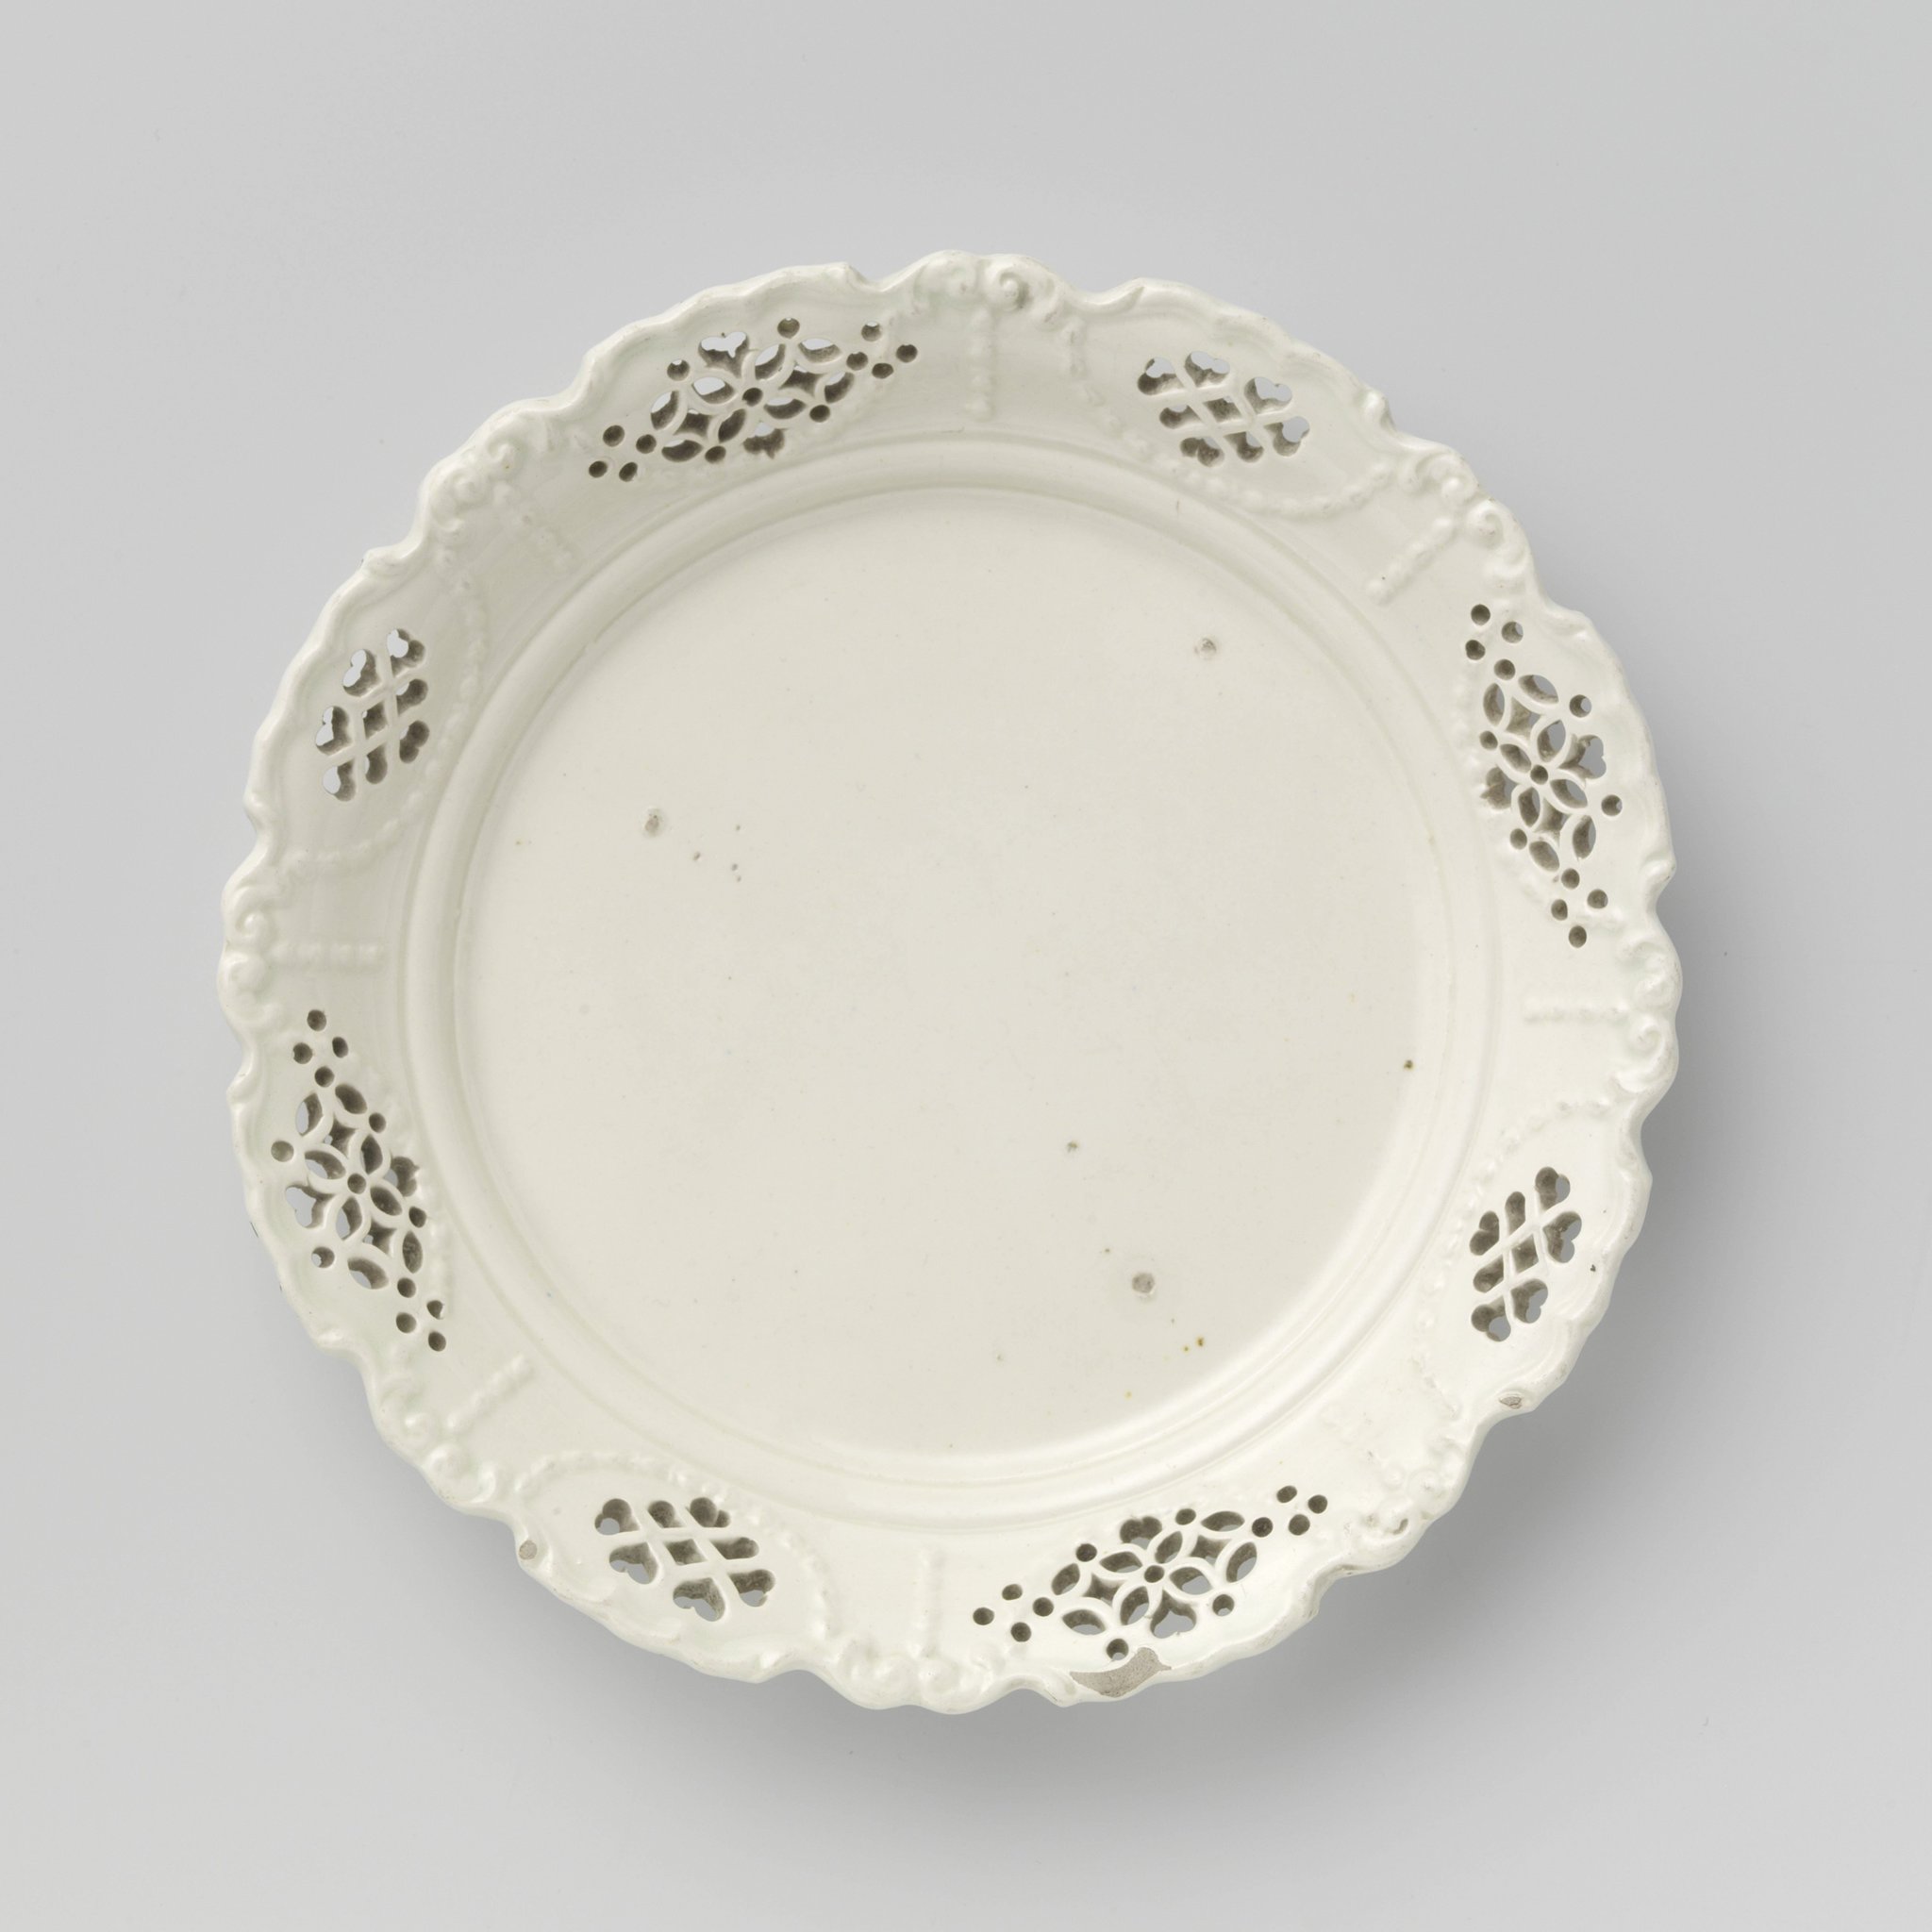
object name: dish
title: Vruchtenschaal van hardgebakken aardewerk, met opengewerkte rand, creamware.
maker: Anonymous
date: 1780-1820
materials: earthenware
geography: england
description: Ronde vruchtenschaal van hardgebakken aardewerk, met een opengewerkte rand. Tussen de opengewerkte medaillons lopen guirlandes en festoenen in reliëf.